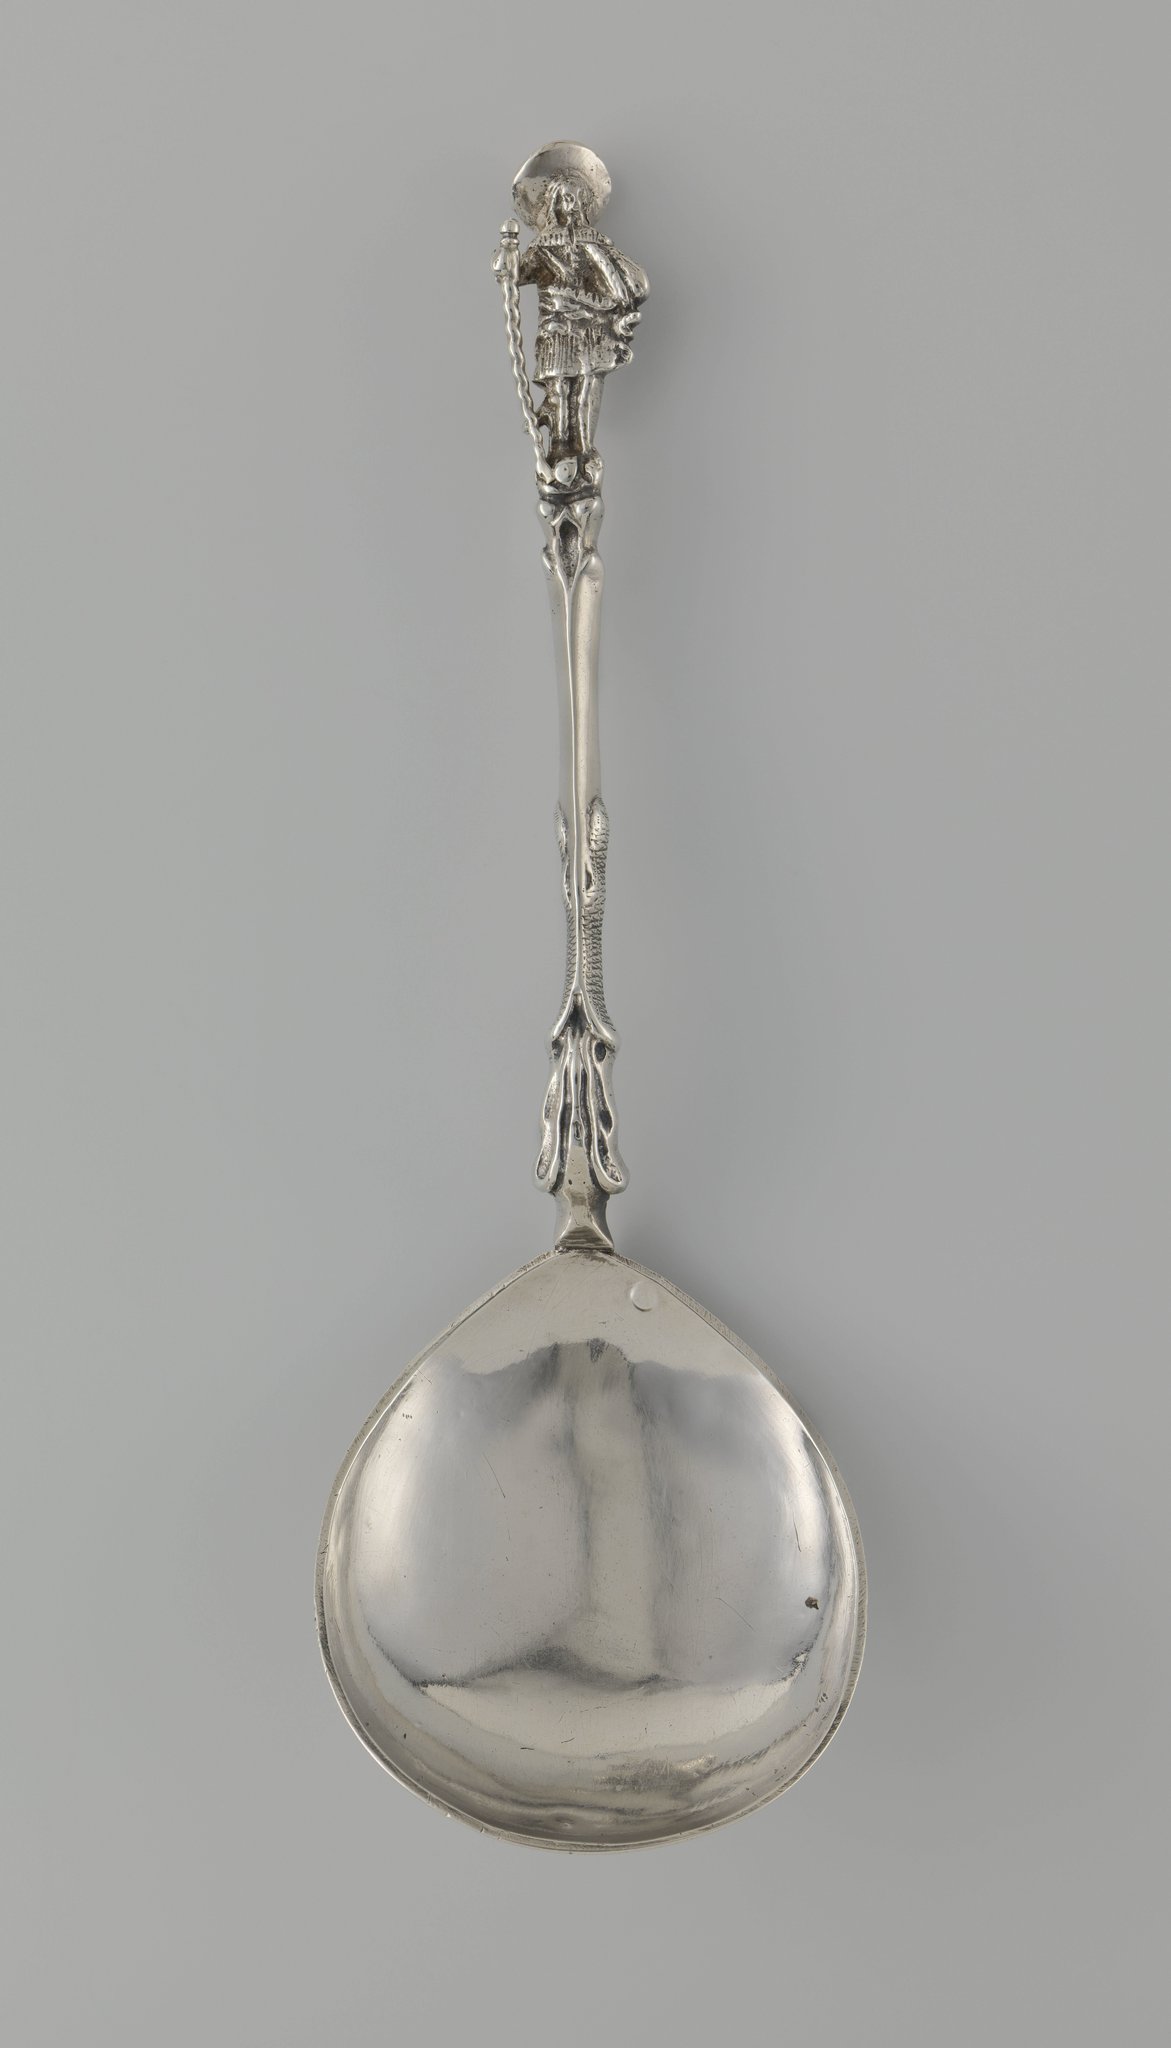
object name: spoon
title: Lepel met peervormige bak en steel bekroond door een man met hoed en wandelstok.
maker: claes bel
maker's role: silversmith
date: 1674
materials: silver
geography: hoorn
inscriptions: maker's mark, : ‘L’, town mark, alloy mark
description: Lepel van zilver, met een peervormige bak. De steel wordt bekroond door een man met hoed en wandelstok. Op de onderzijde van de bak zijn de letters G.D gegraveerd.